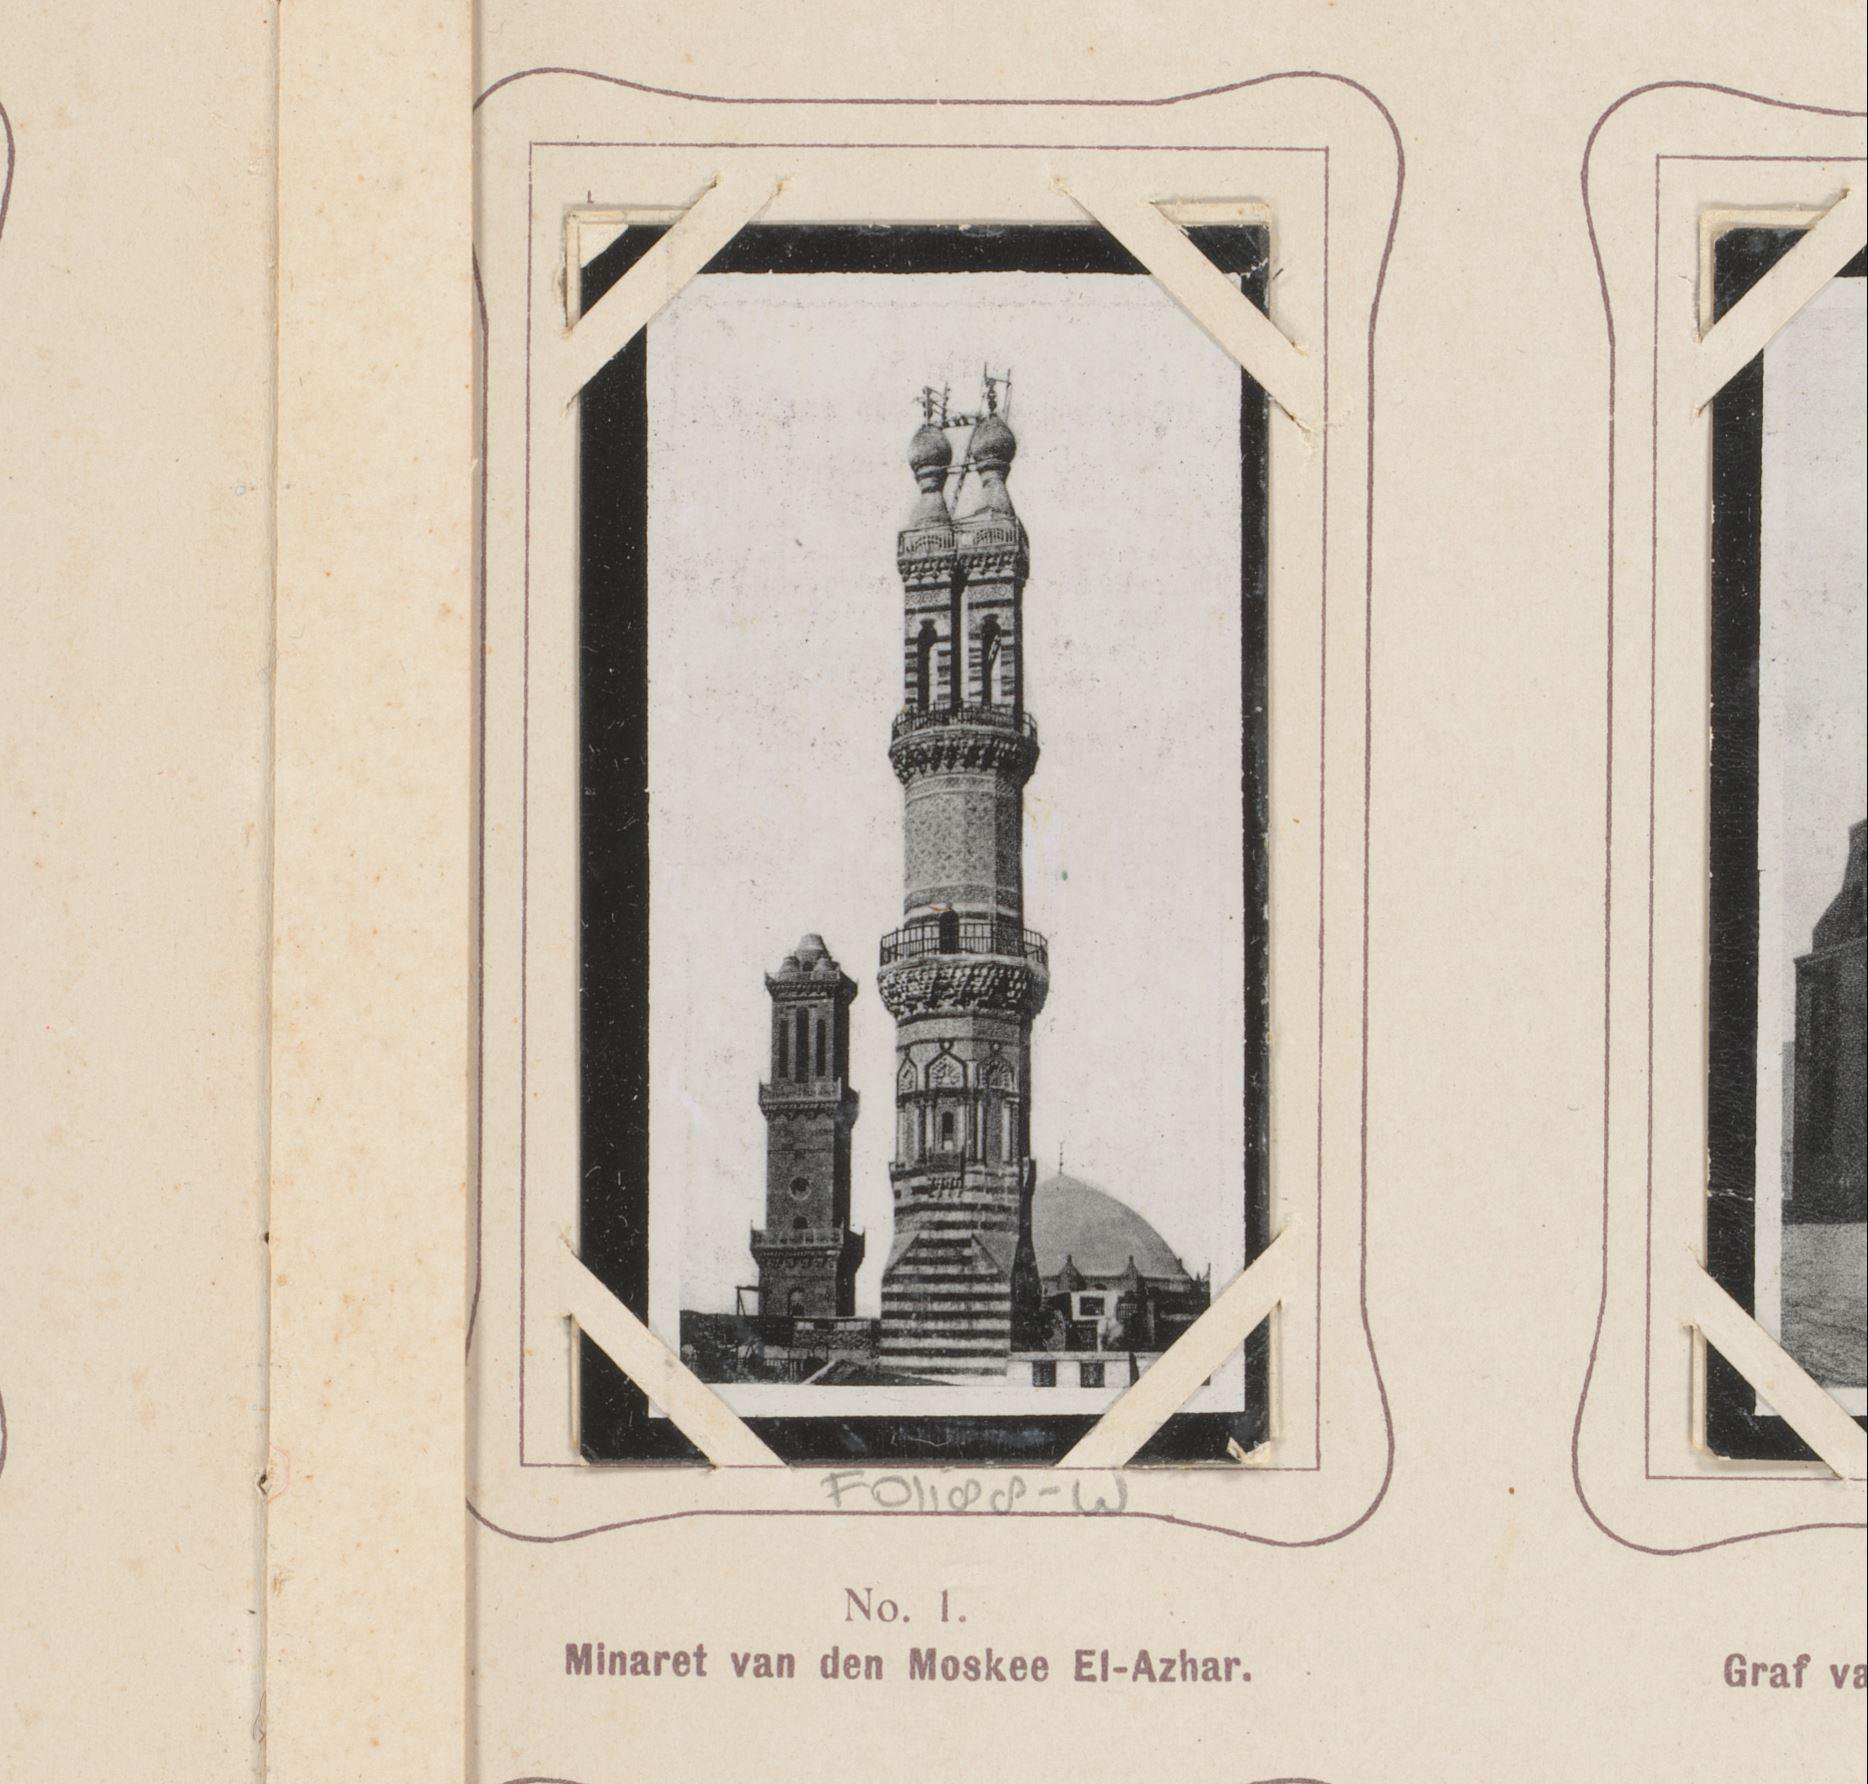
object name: album leaf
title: Minaret van de Al-Azhar-moskee te Caïro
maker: Anonymous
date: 1906-1907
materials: paper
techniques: photograph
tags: temple, shrine ~ islam, mohammedanism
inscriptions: inscription: ‘No. 1./ Minaret van den moskee El-Azhar.’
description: Deze prent maakt deel uit van een album.